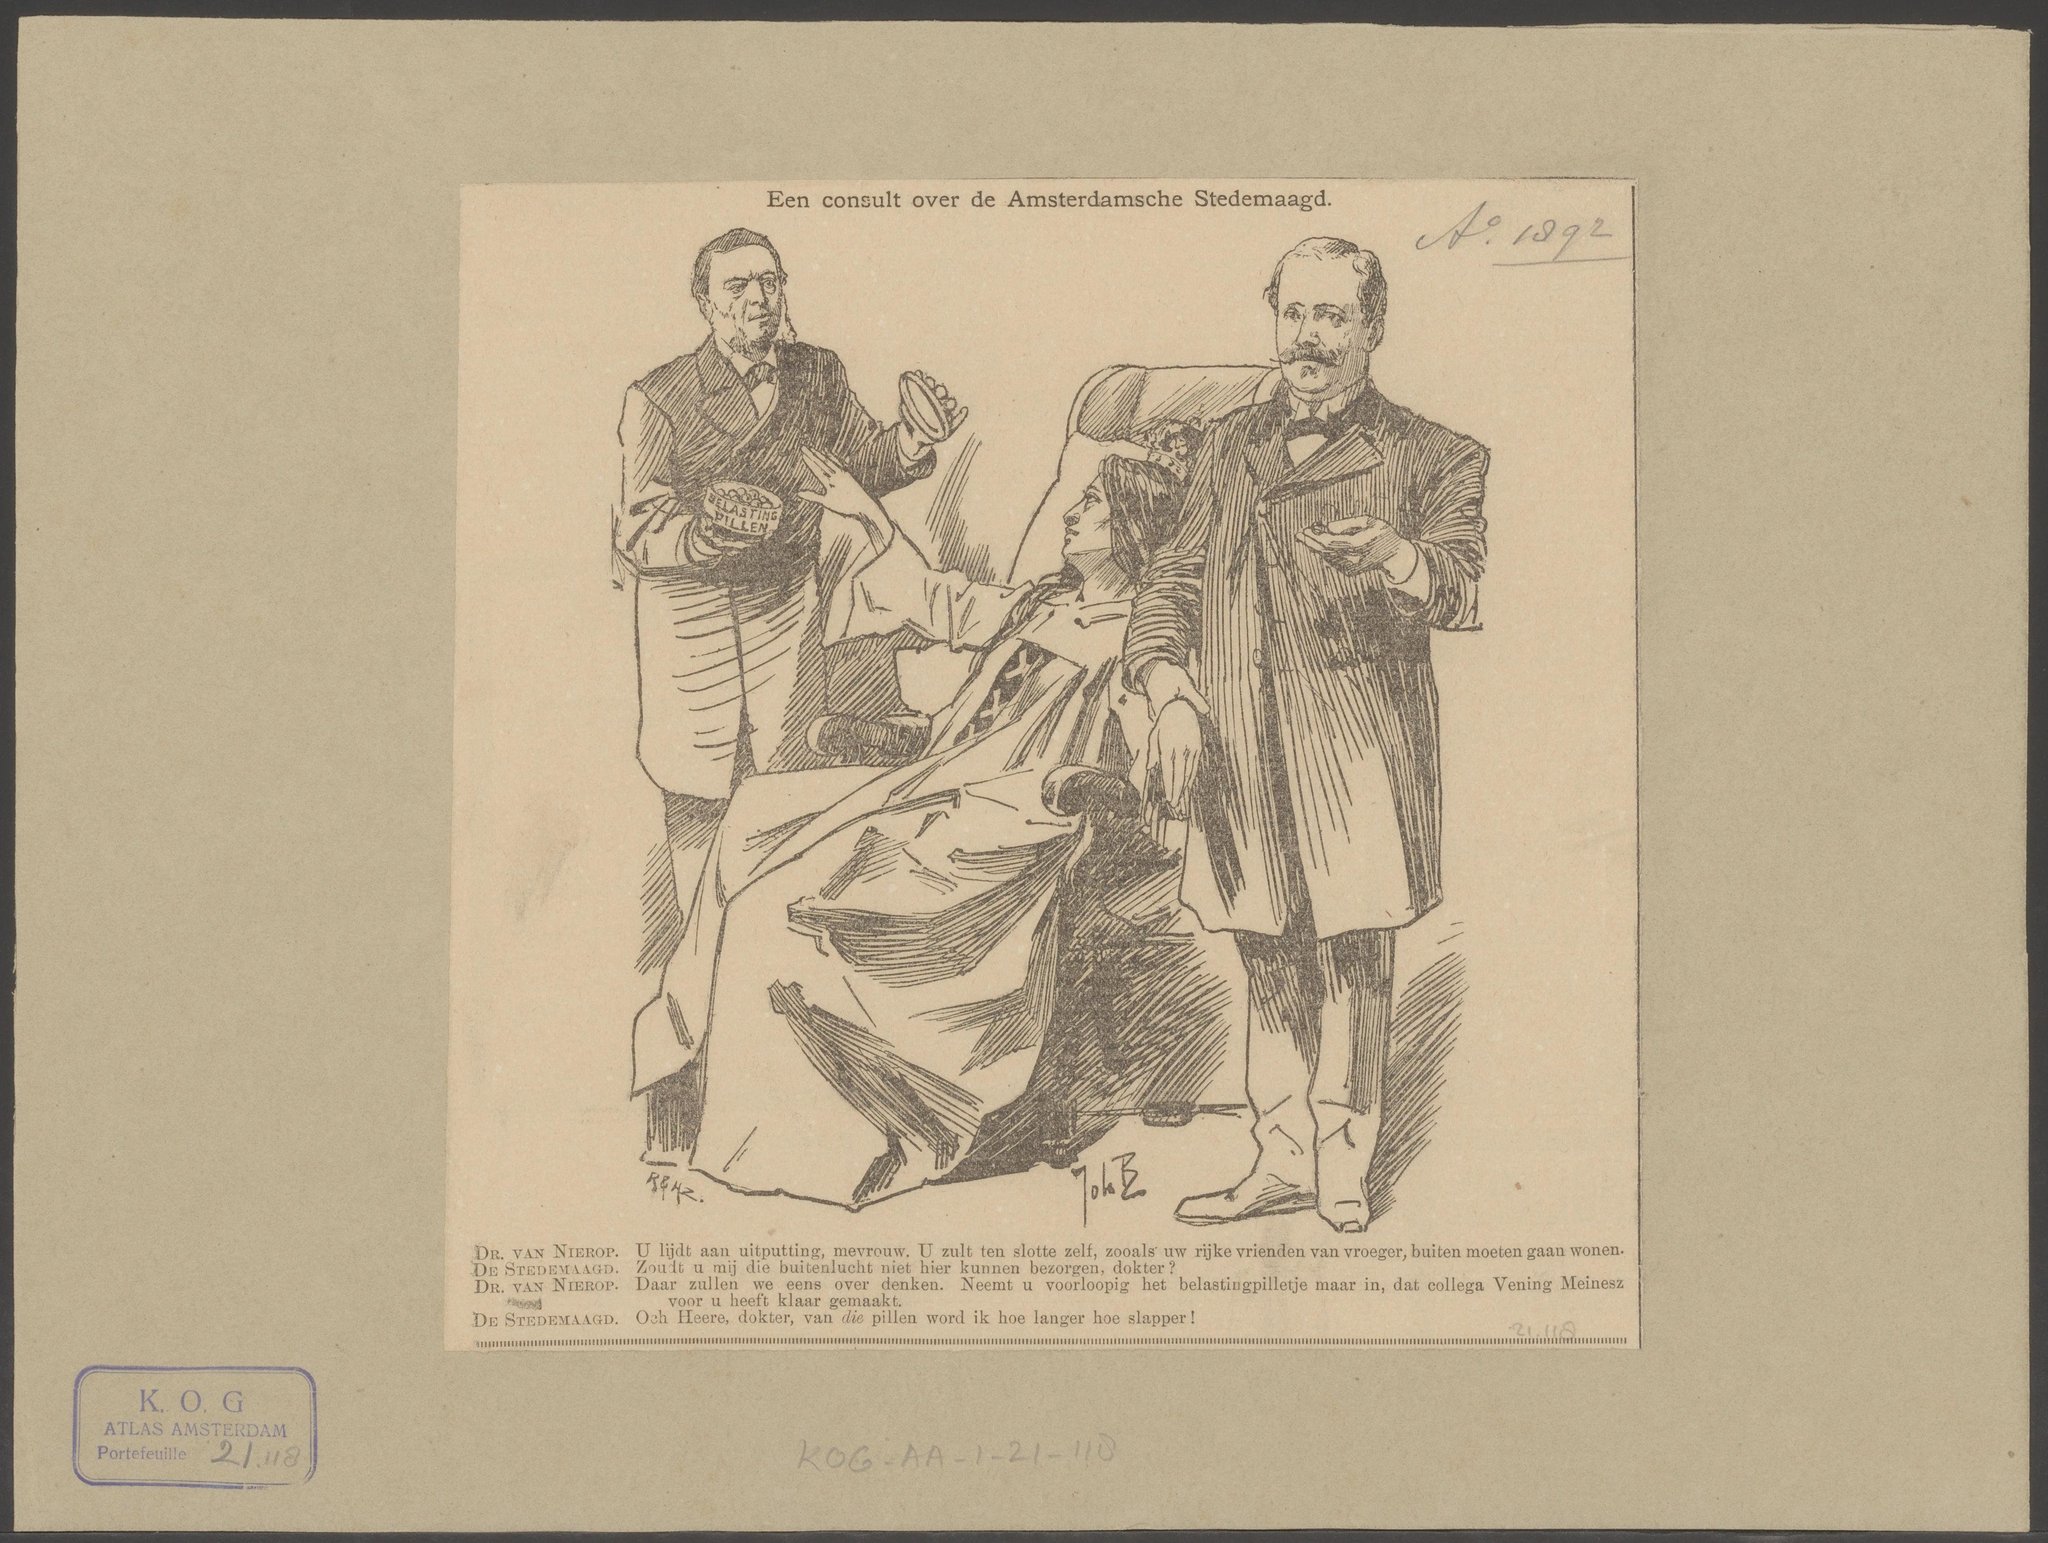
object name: photomechanical print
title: Stedenmaagd van Amsterdam krijgt doktersbezoek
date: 1892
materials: paper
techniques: letterpress printing, line block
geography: netherlands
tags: harlingen, personification of a city, town-patron(ess), administering, taking medicine, patient, sick person, examination, diagnosis; physician speaking with patient, feeling pulse or heart-beat, political caricatures and satires, amsterdam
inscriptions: collector's mark: Lugt 1641b, inscription: ‘A◦. 1892’, signature: ‘R&HZ.’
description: Links burgemeester van Amsterdam Sjoerd Anne Vening Meinesz als dokter die 'belastingpillen' aanbiedt, rechts gemeenteraadslid Frederik Salomon van Nierop als dokter die de pols voelt. Onderwerpsrubriek binnen de Atlas Amsterdam: Belastingen.